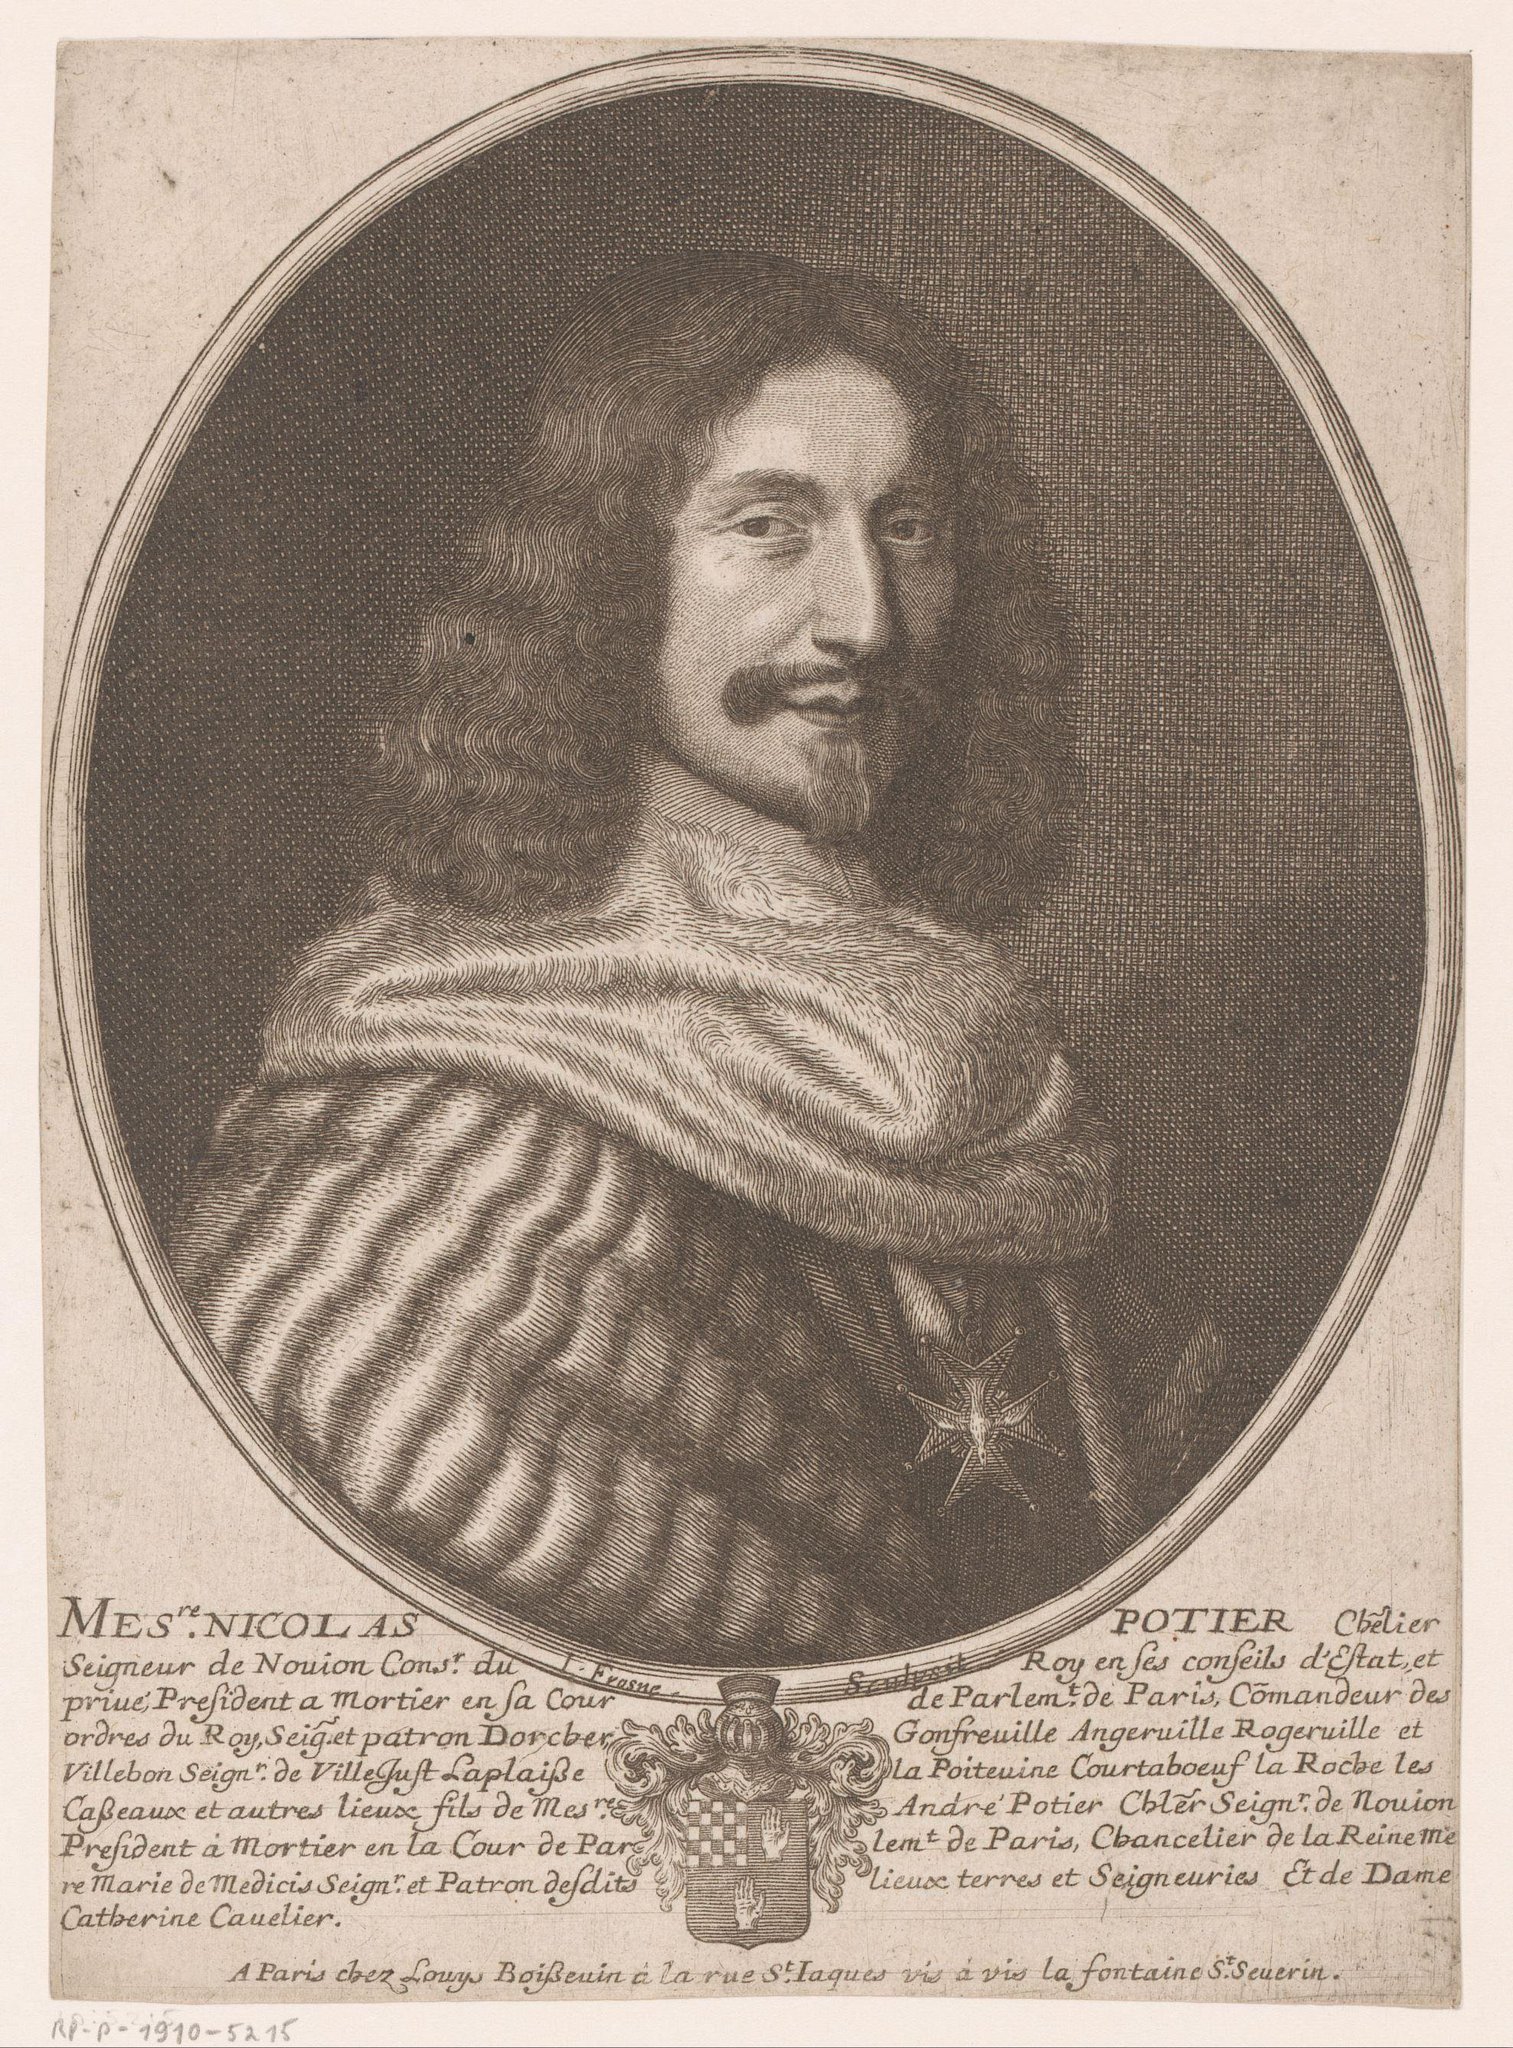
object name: print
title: Portret van Nicolas Potier de Novion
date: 1633-1676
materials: paper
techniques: engraving, etching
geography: france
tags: ornament ~ medallion, historical persons, armorial bearing, heraldry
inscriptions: collector's mark: Lugt 2228